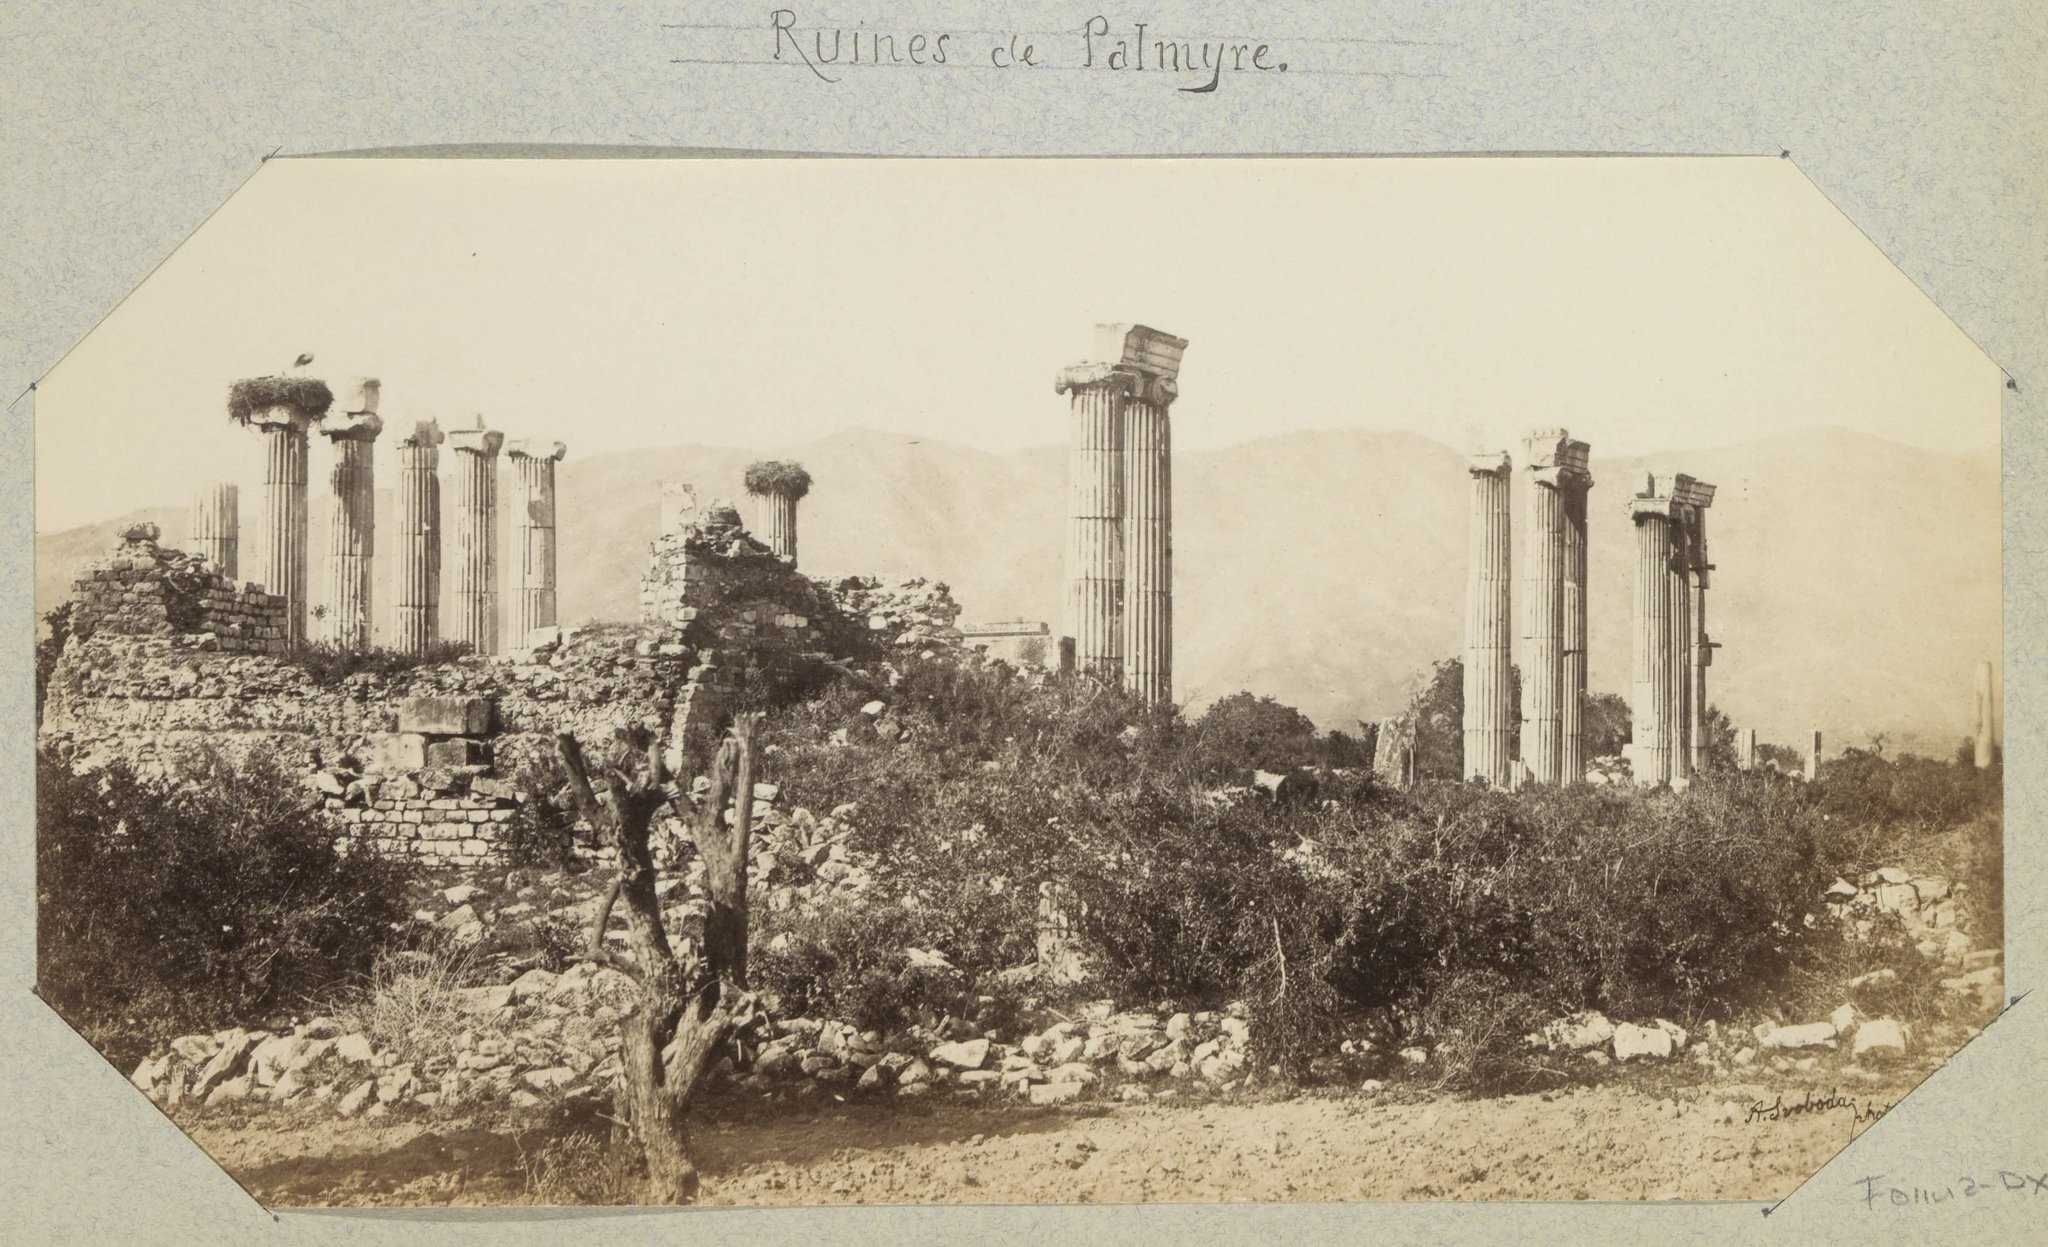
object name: album leaf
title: Restanten van gebouwen met pilaren in Palmyra (Syrië)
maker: alexander svoboda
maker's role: fotograaf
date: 1880-1900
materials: paper, photographic support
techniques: albumen print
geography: palmyra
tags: column, pillar ~ architecture, ruin of a building ~ architecture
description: Onderdeel van Album van een Franse amateur met foto's van Frankrijk, Algerije, Palmyra, de Wereldtentoonstelling van 1900 en van bekende Fransen.